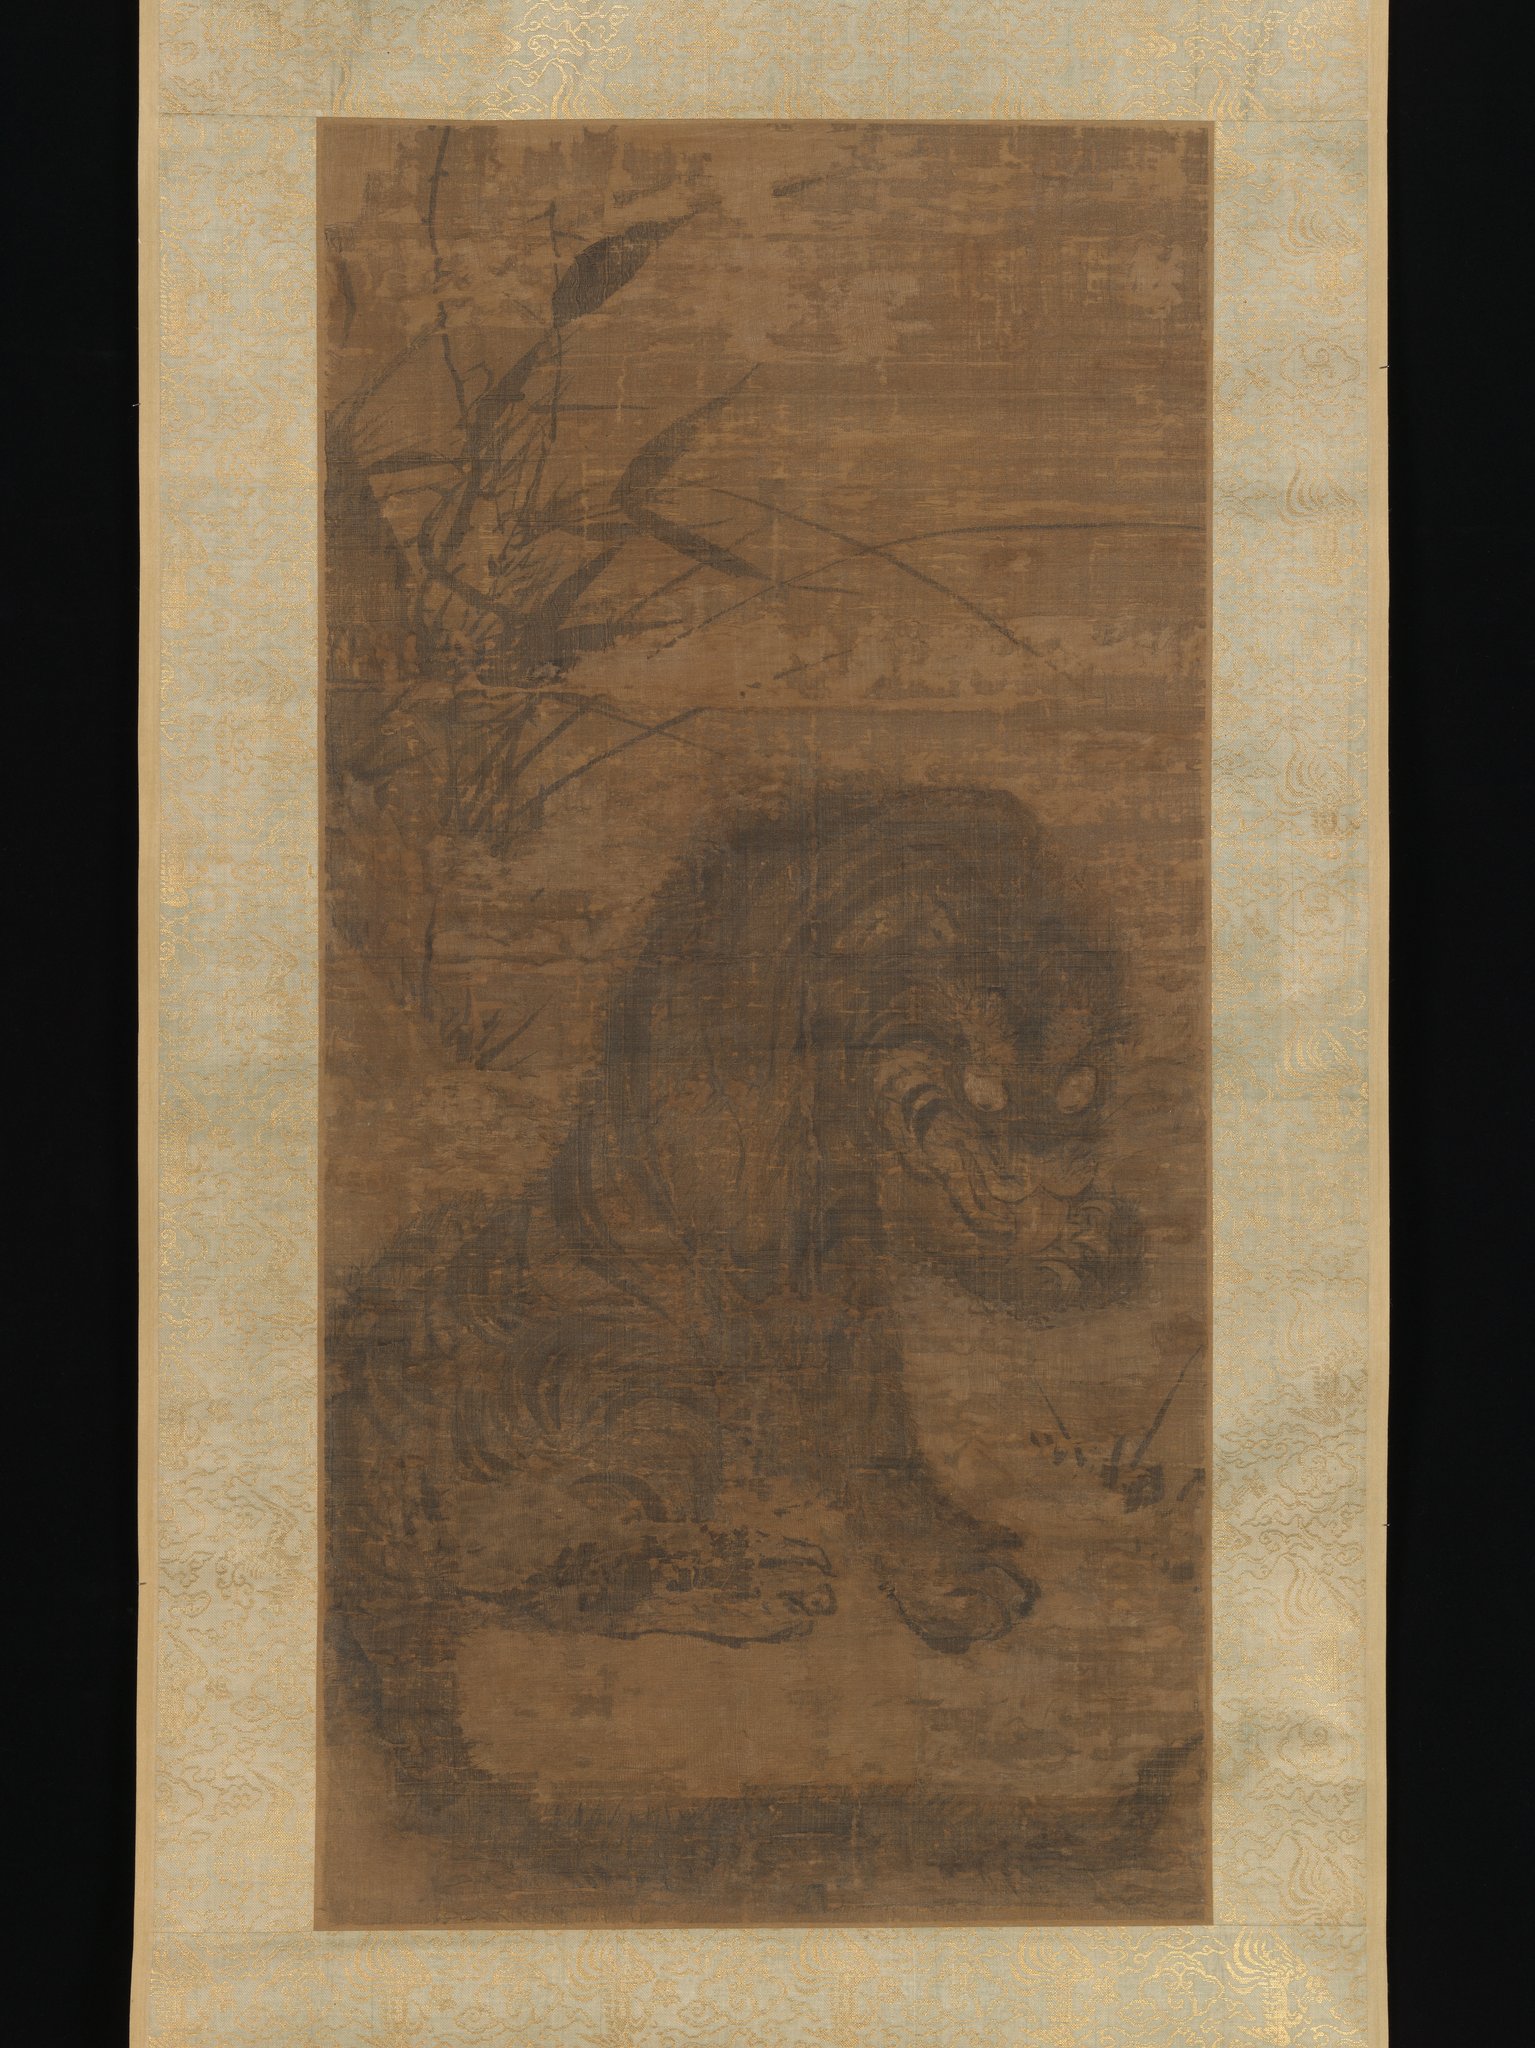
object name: hanging scroll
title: Tiger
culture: chinese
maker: unidentified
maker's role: artist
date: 1301-1400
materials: ink, silk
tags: tigers